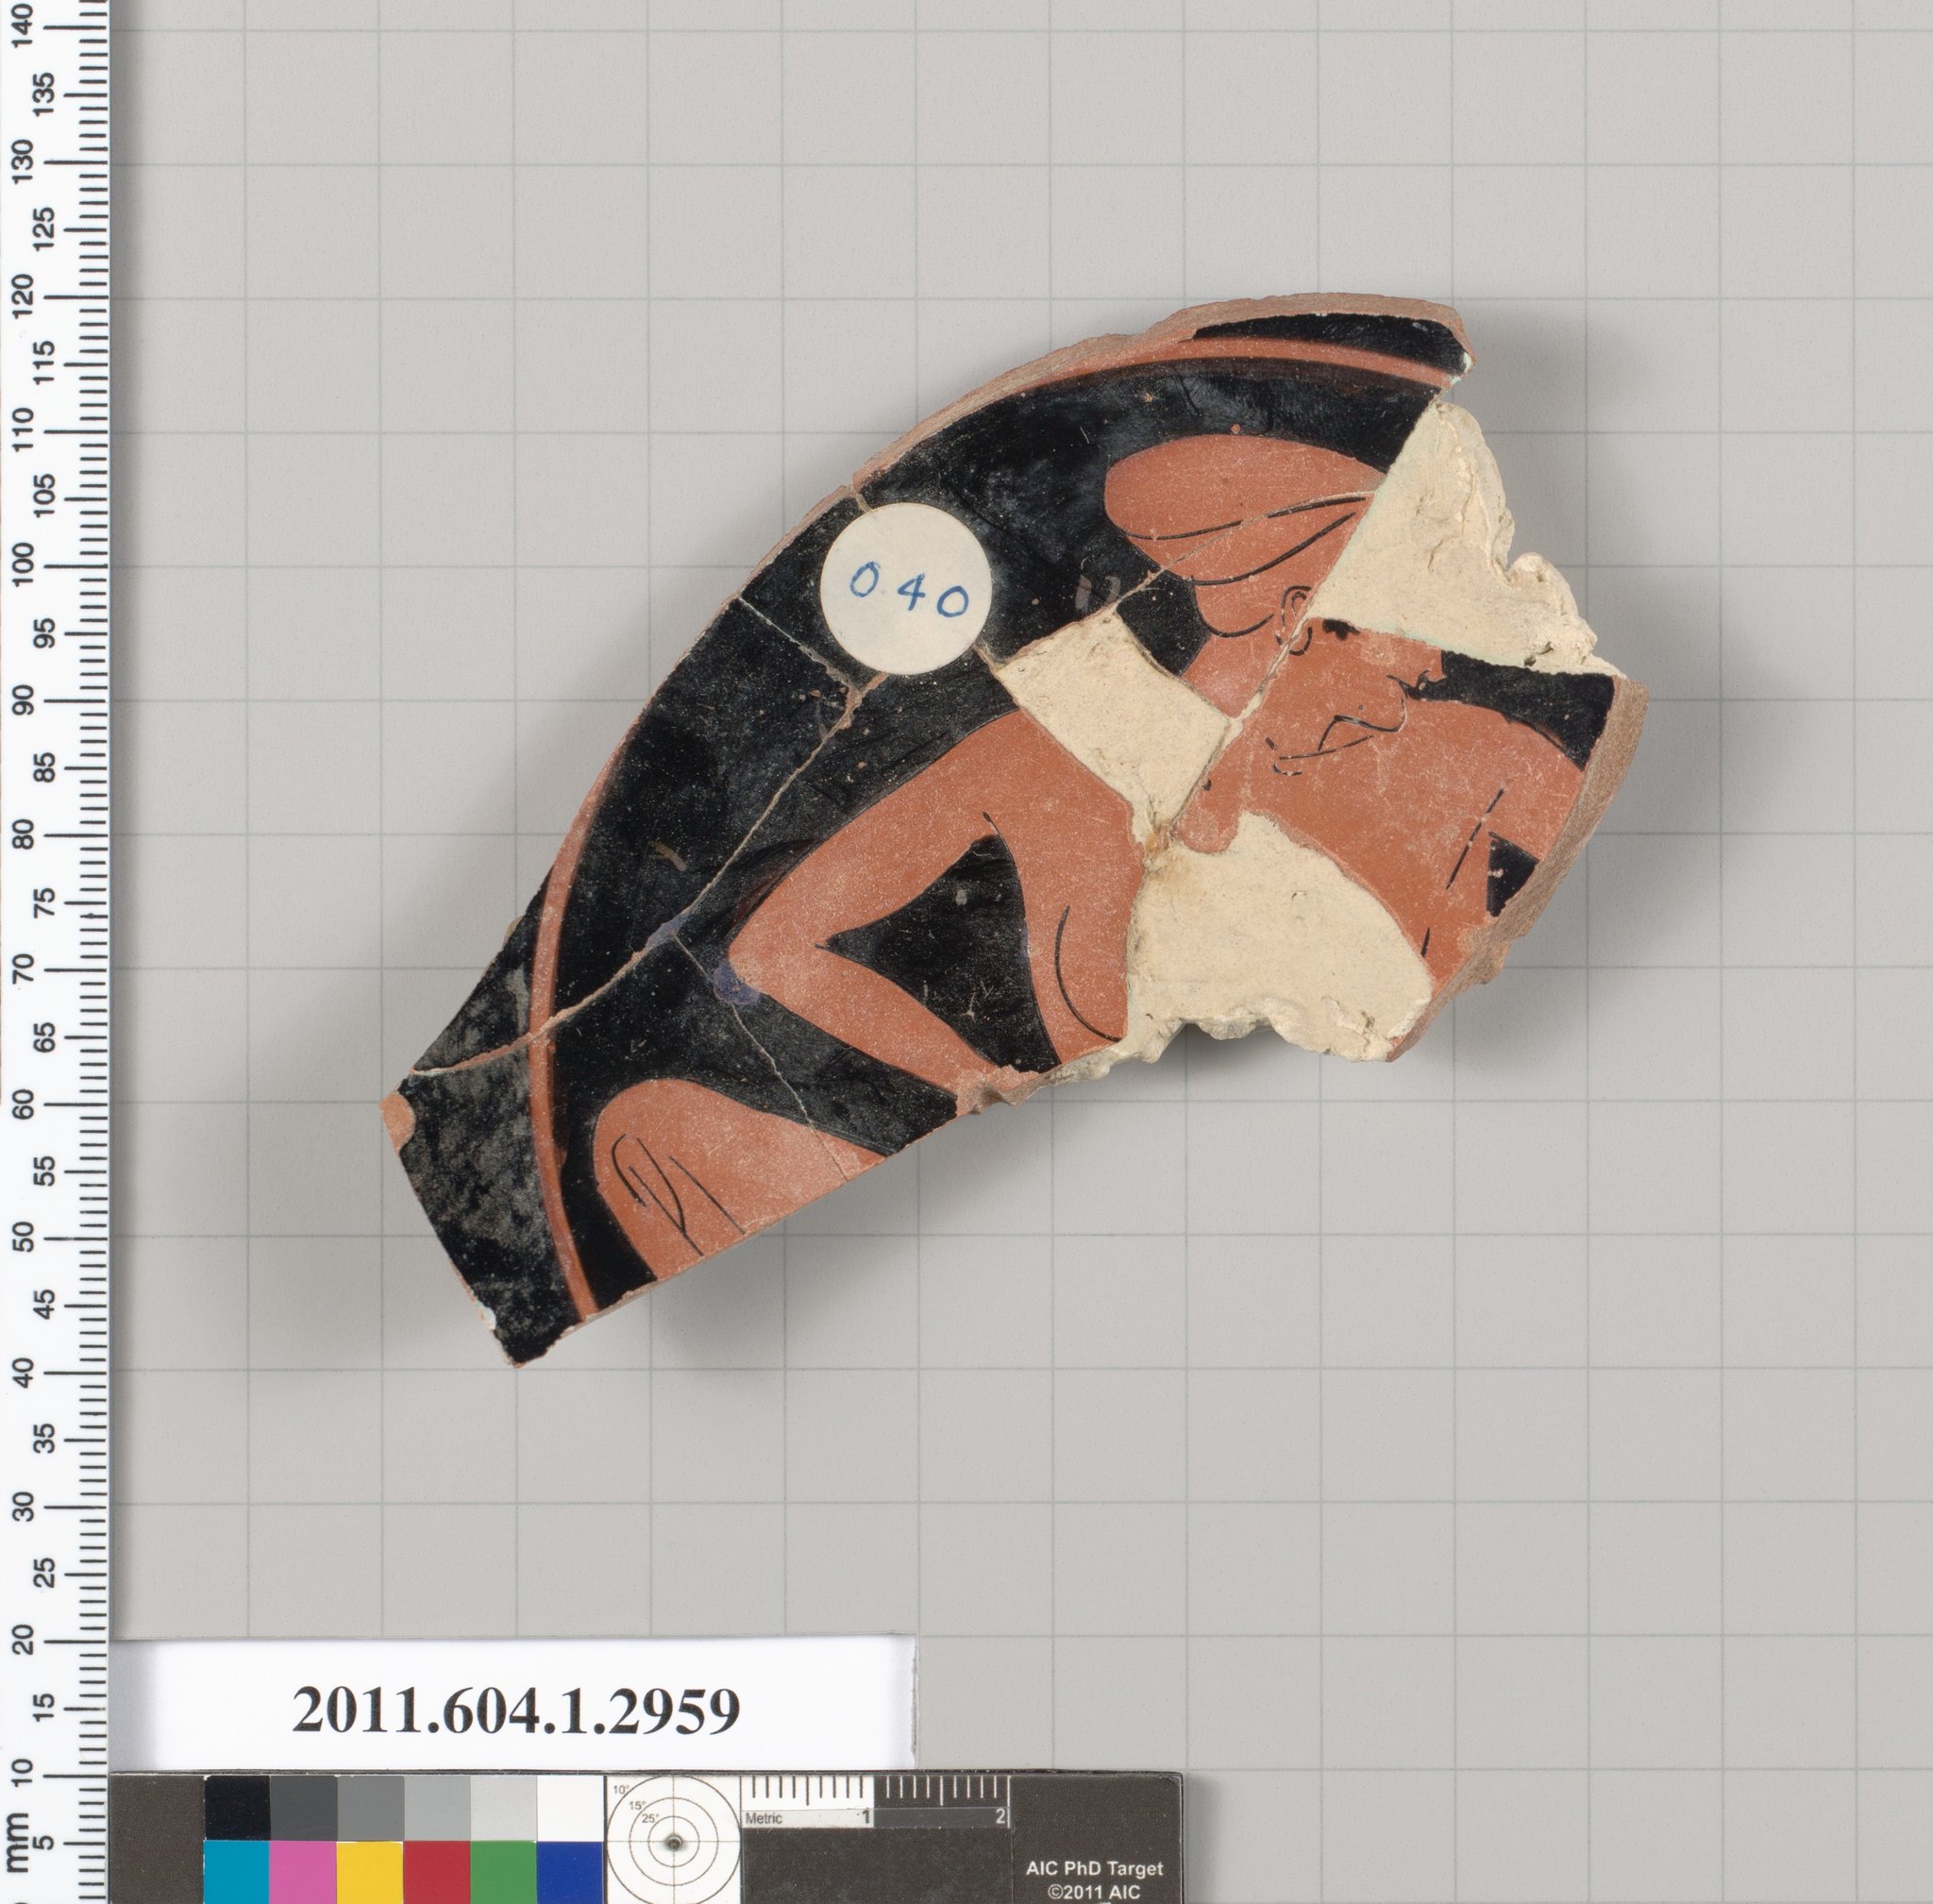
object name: kylix fragment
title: Terracotta fragment of a kylix (drinking cup)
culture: greek, attic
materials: terracotta